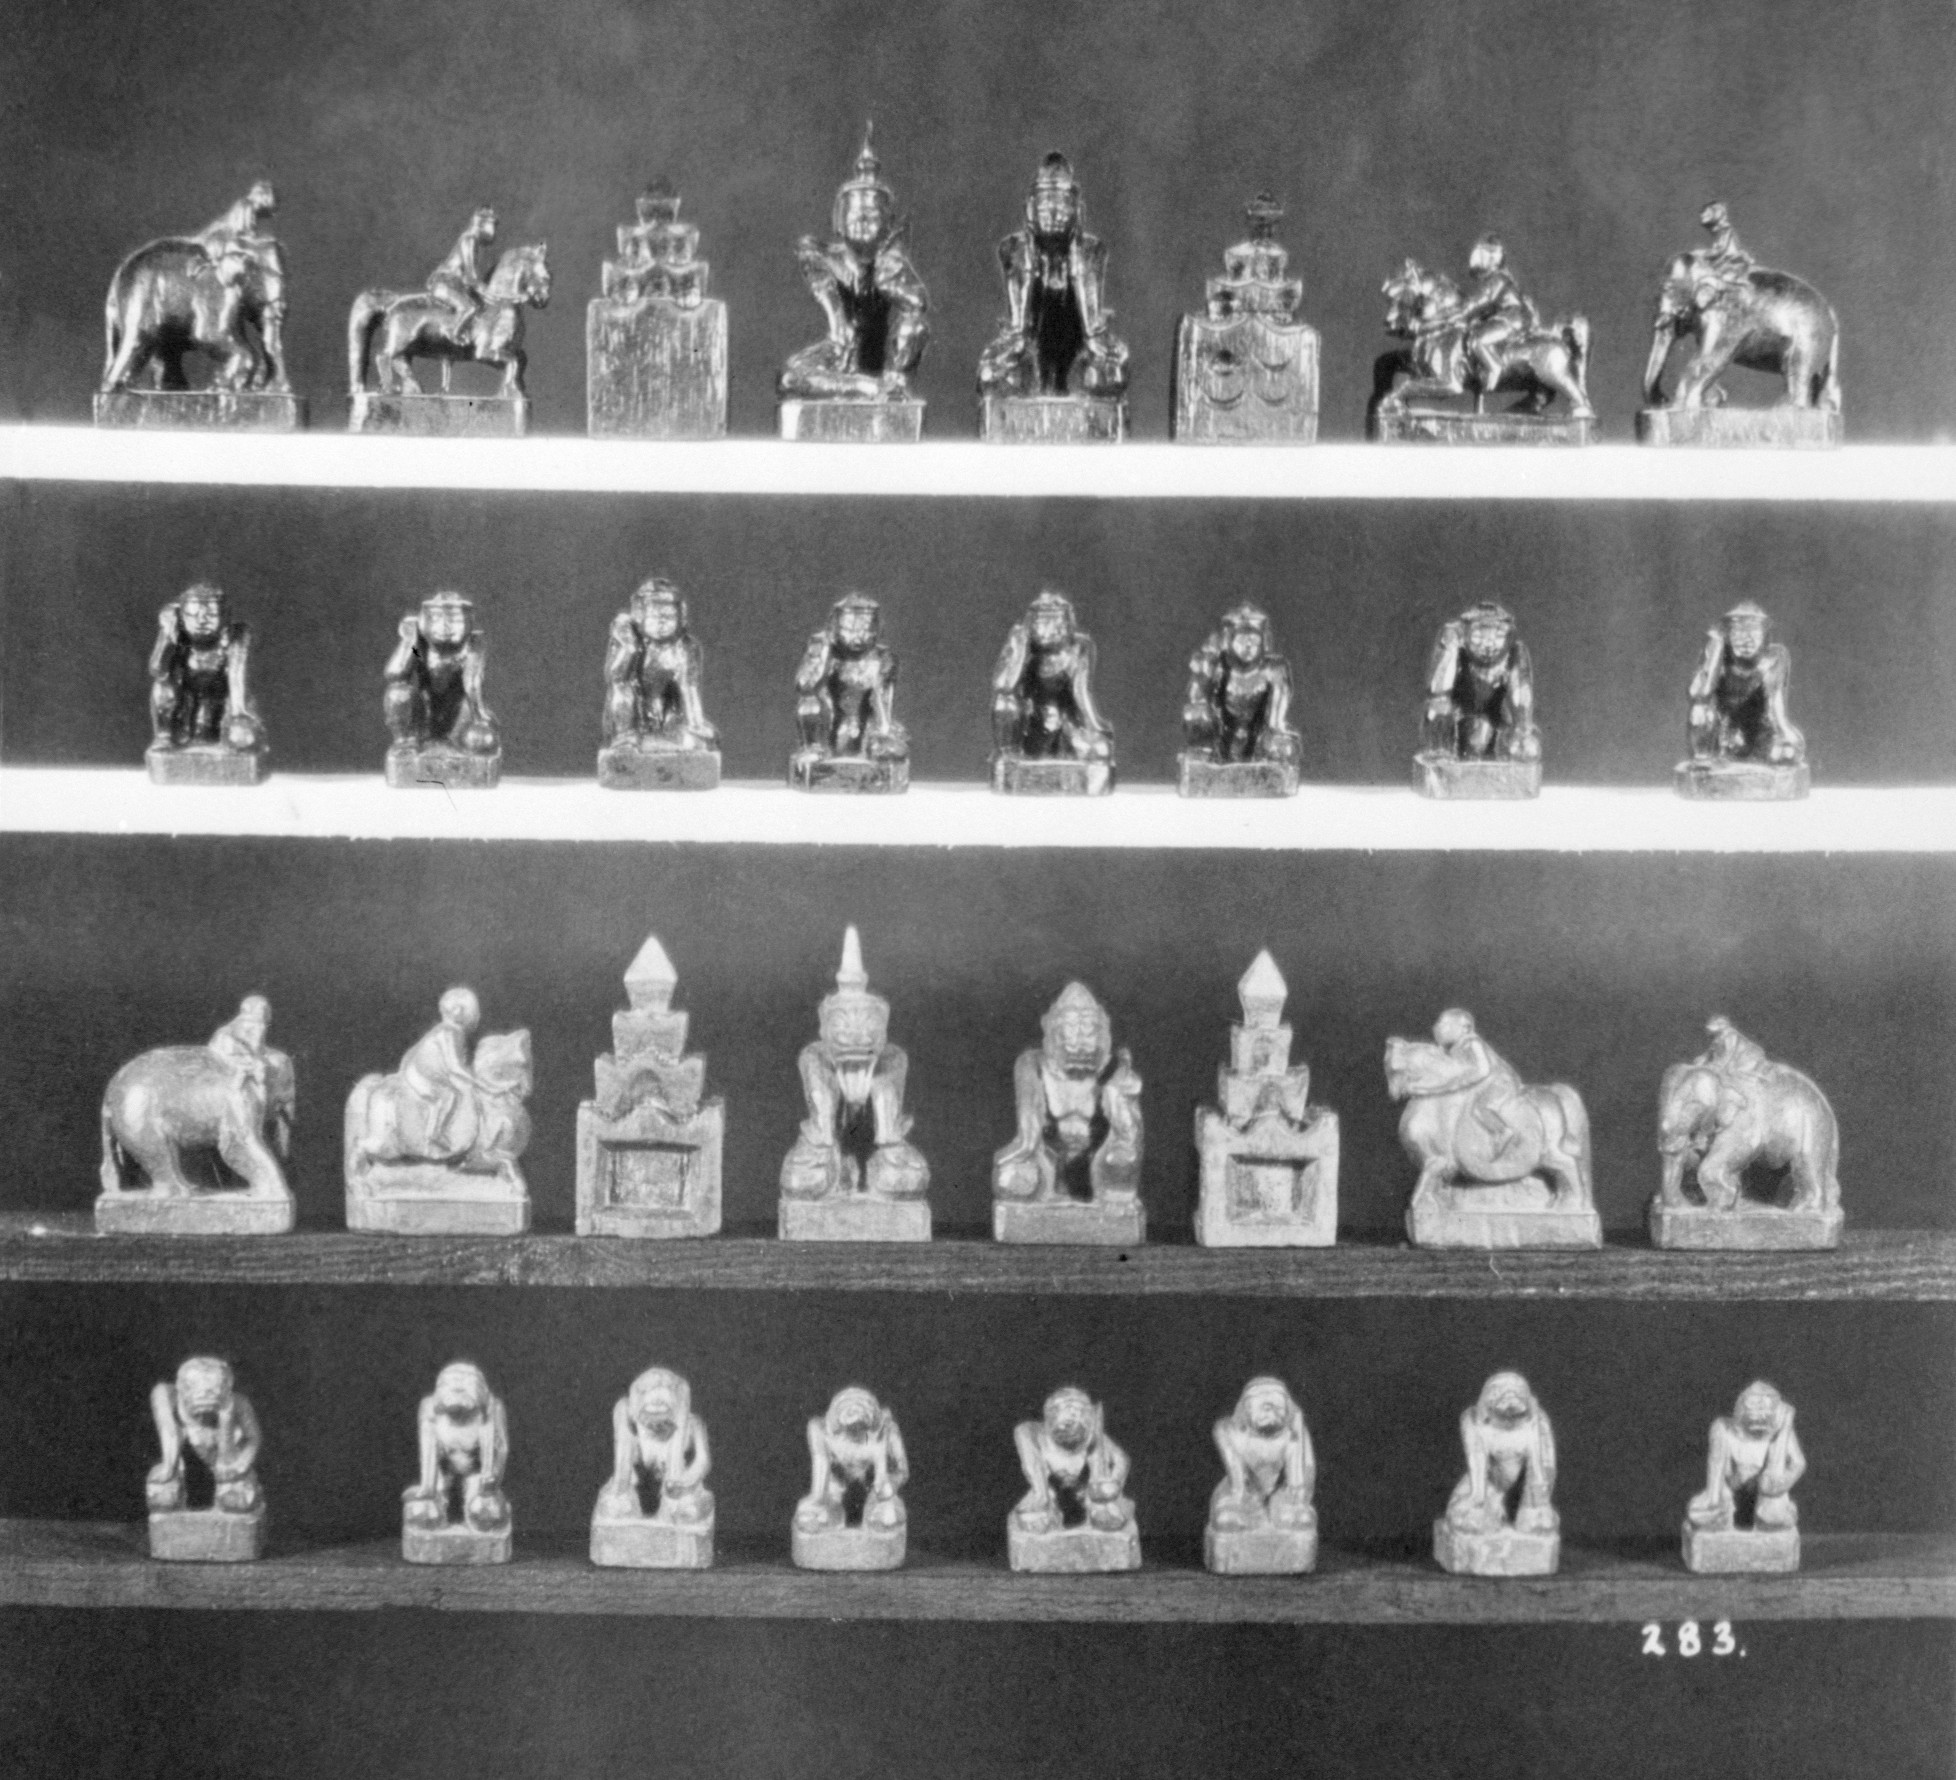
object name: chessman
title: Chessmen (32)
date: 1801-1900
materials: wood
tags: chess